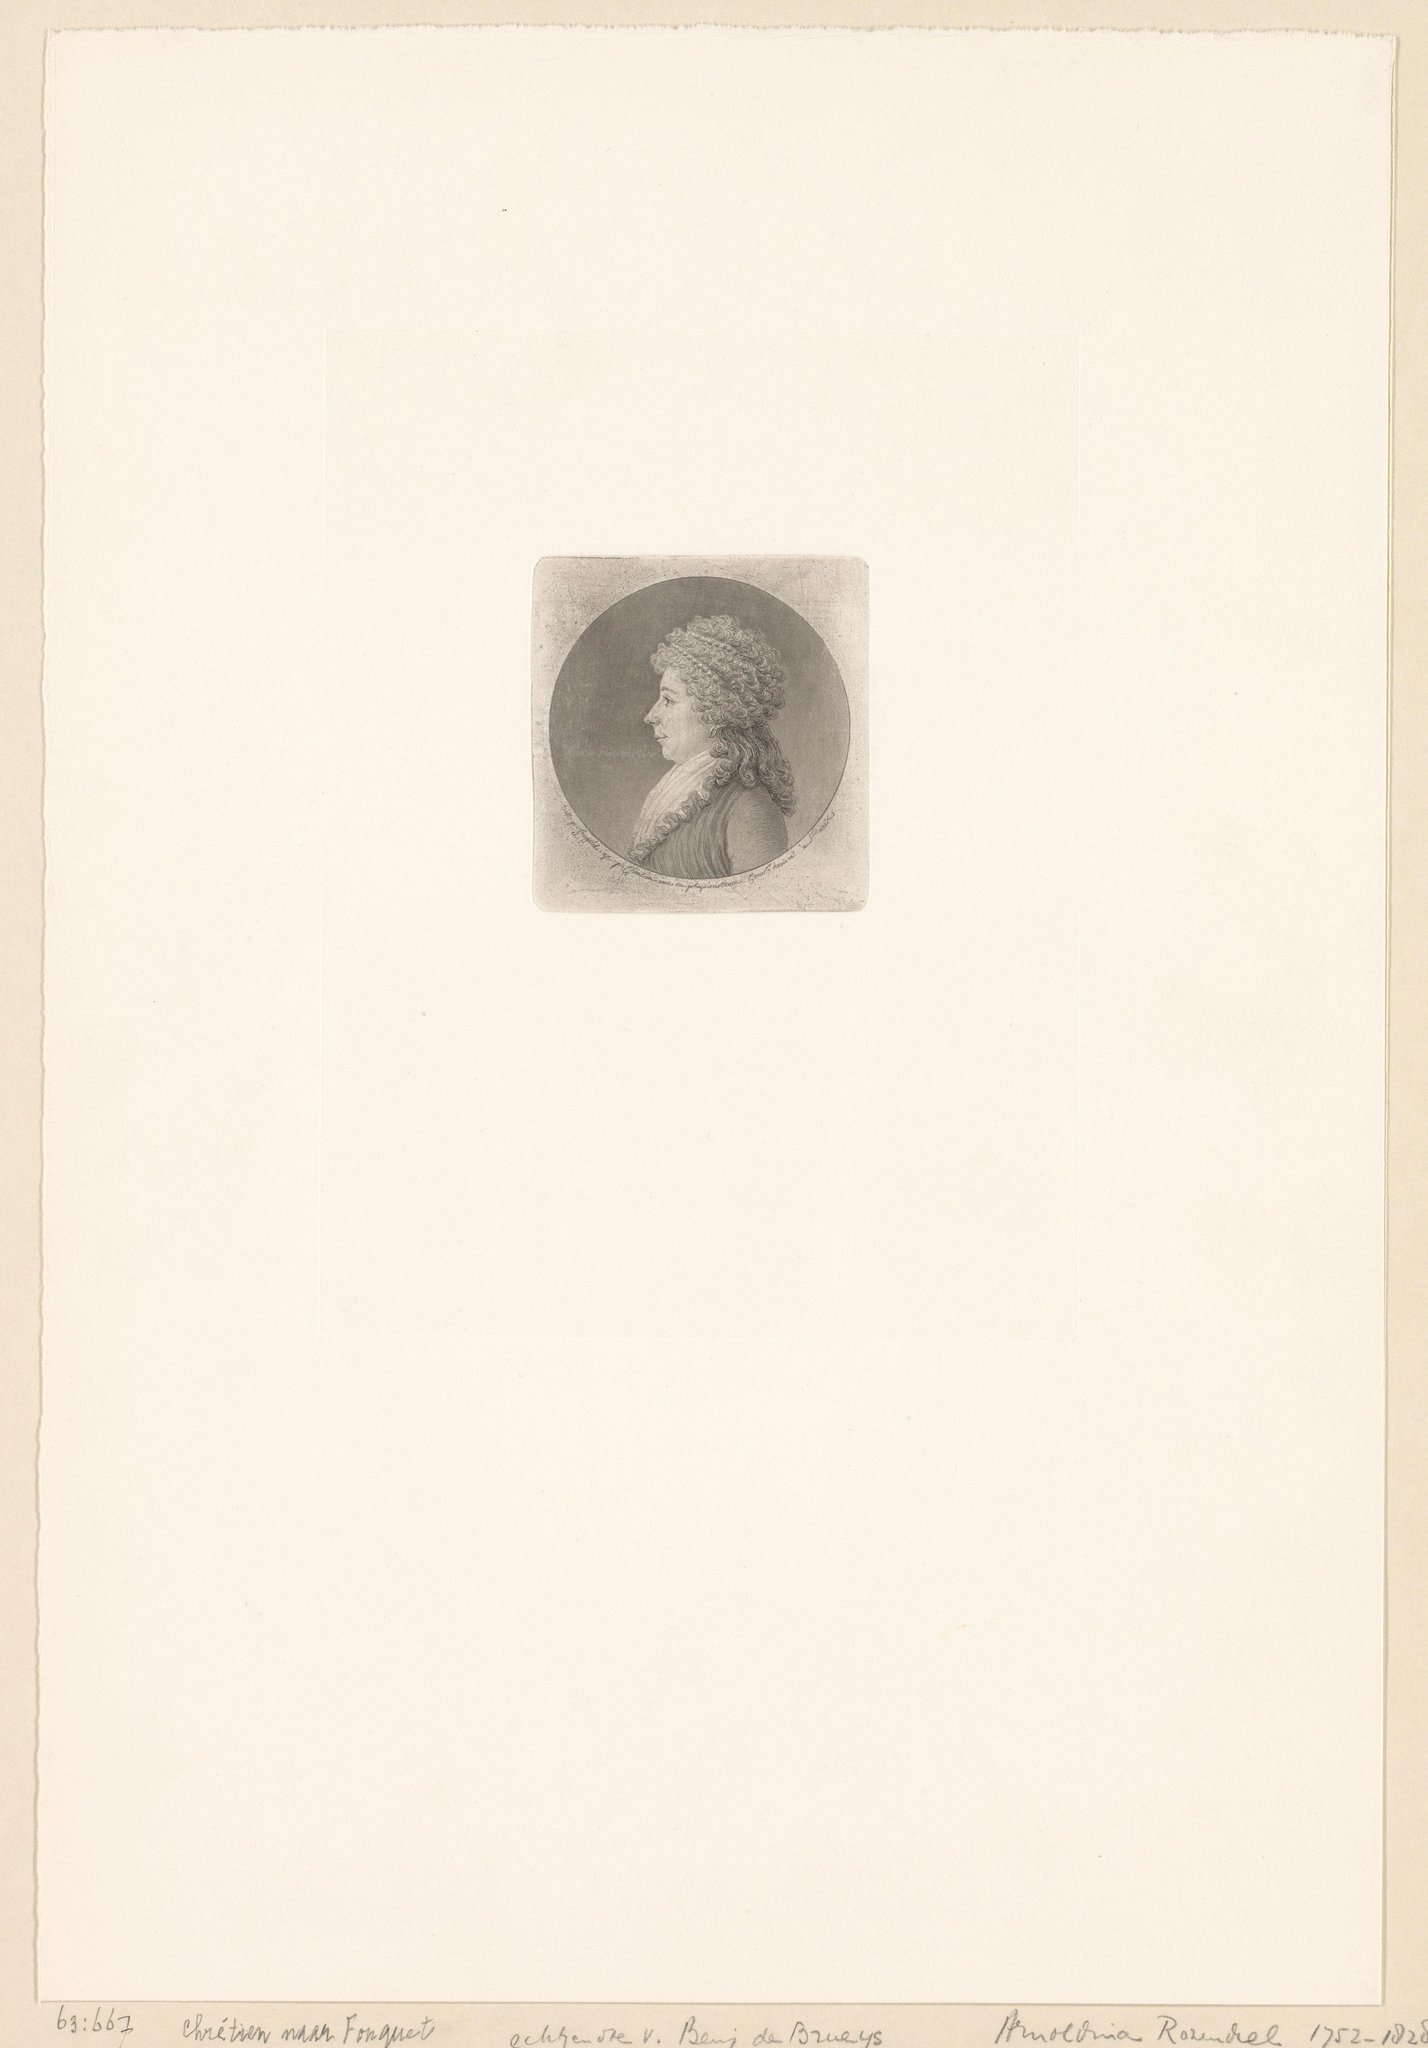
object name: physionotrace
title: Portret van Arnoldina Rozendaal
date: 1935-1963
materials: paper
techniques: aquatint, etching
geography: paris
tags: silhouette-apparatus, 'physionotrace', historical persons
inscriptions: collector's mark: Lugt 2228